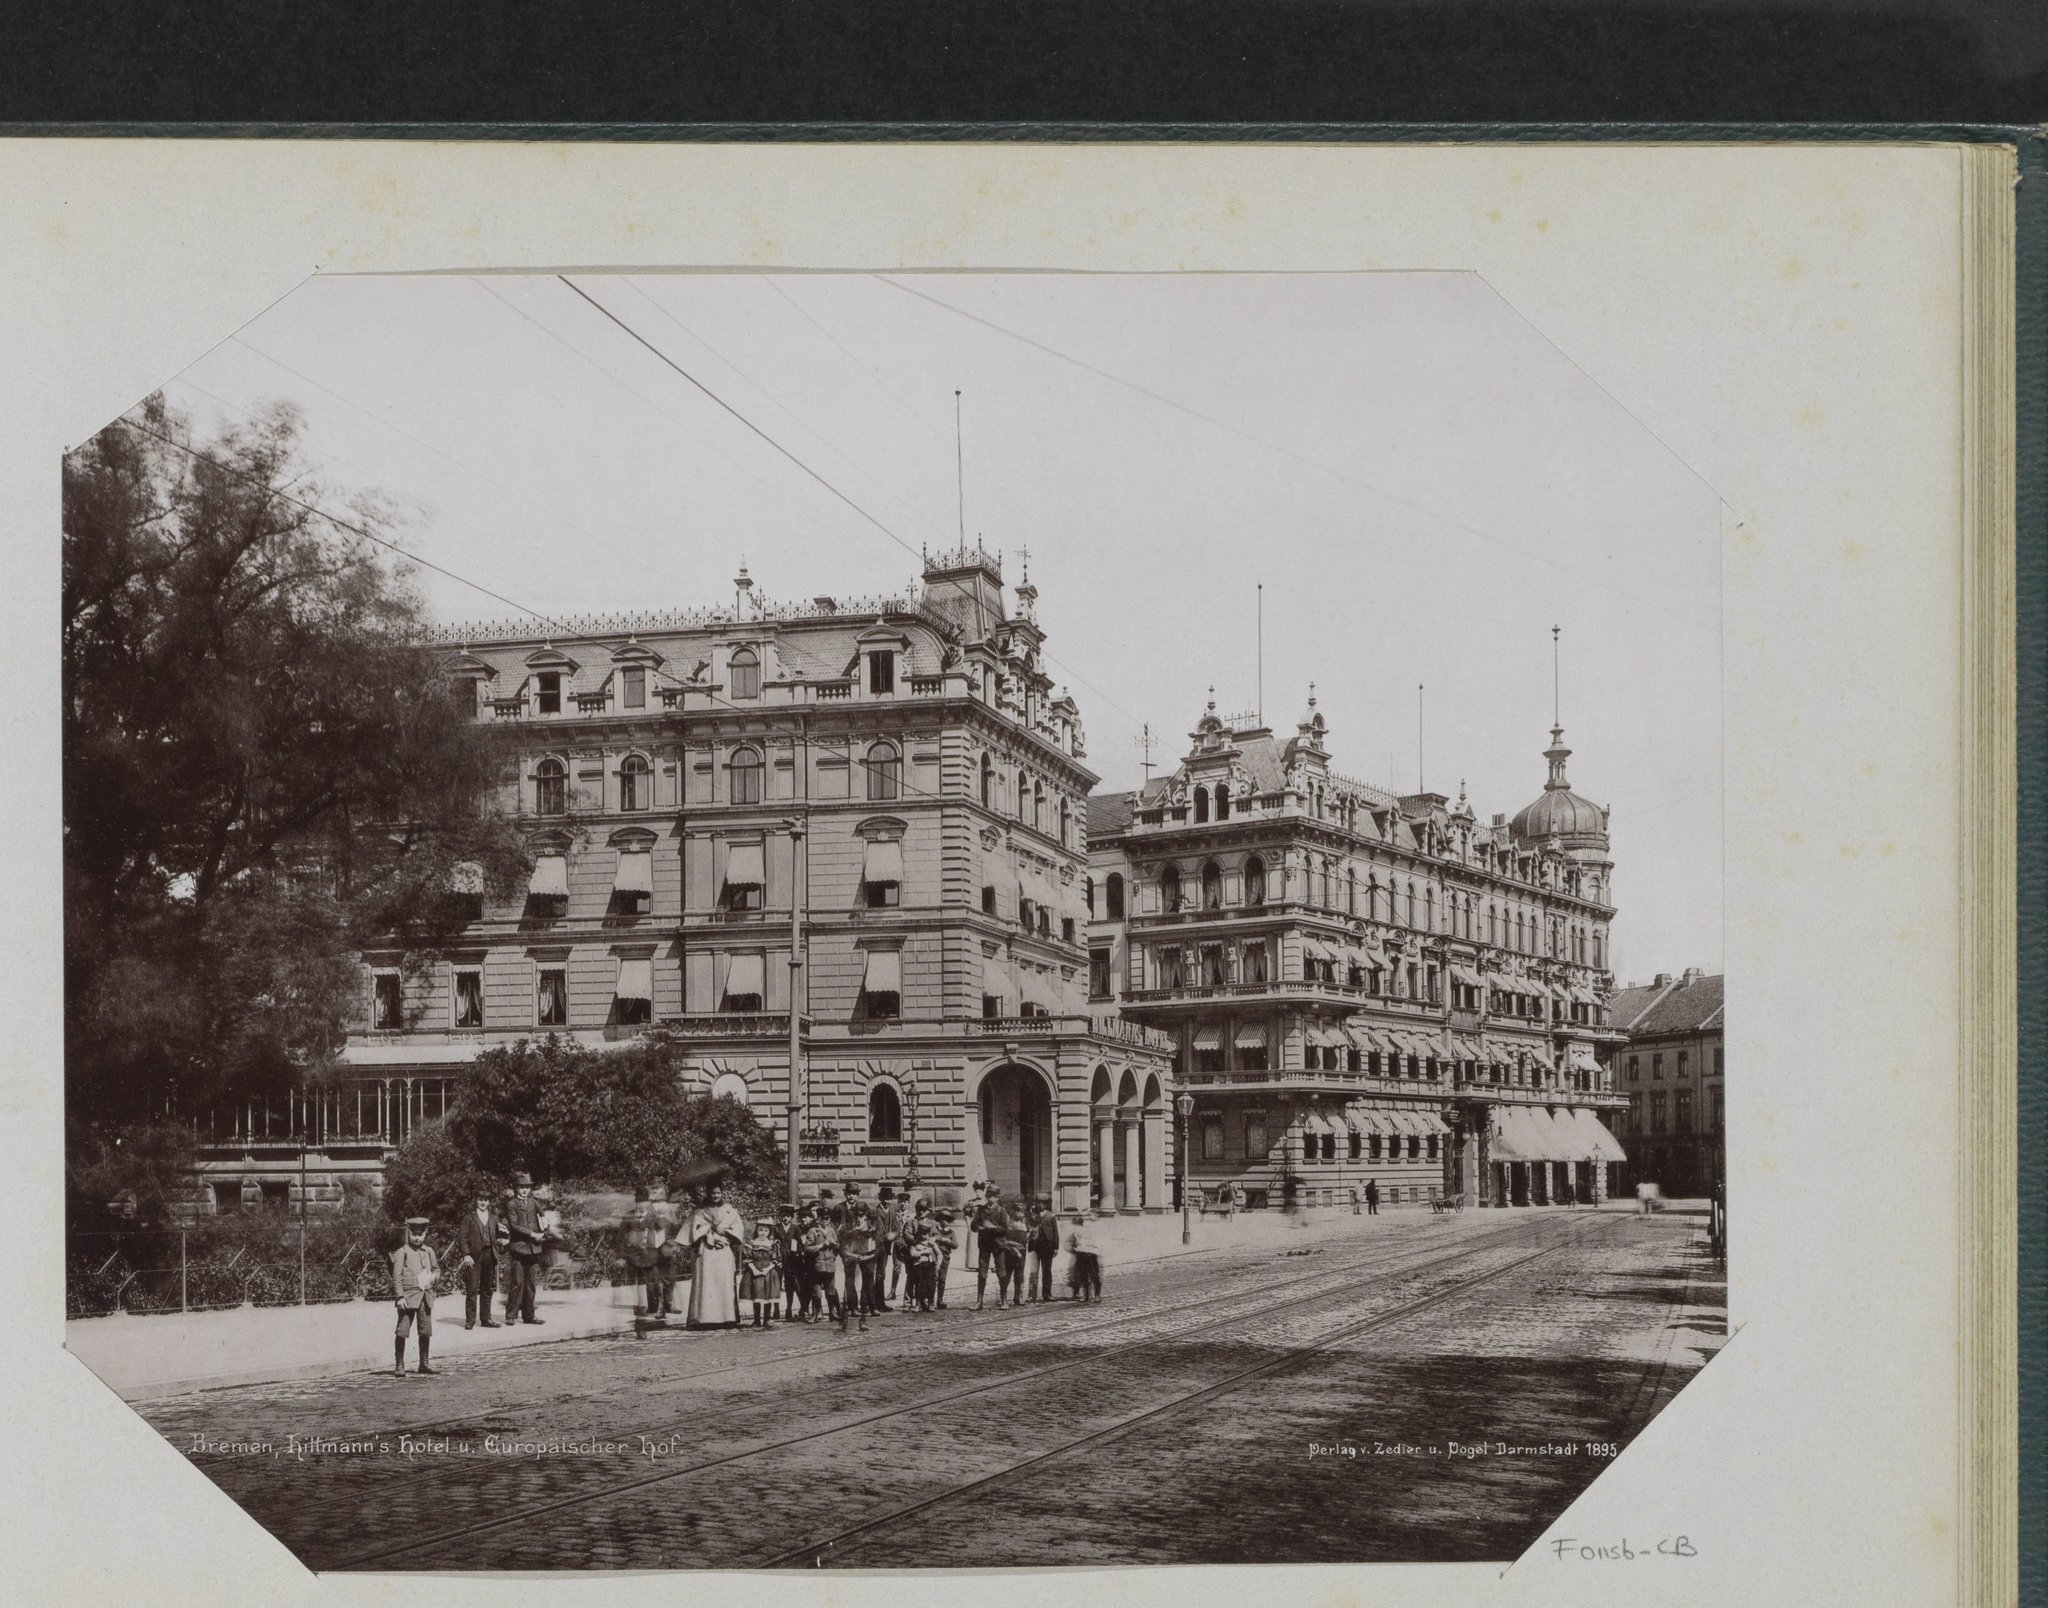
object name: album leaf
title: Gezicht op Hillmann's Hotel te Bremen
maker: Anonymous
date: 1895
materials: paper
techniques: photograph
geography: darmstadt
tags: hotel, hostelry, inn, street (+ city(-scape) with figures, staffage)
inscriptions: inscription: ‘Bremen, Hillmann's Hotel u. Europäischer Hof/ Verlag v. Zedler u. Vogel Darmstadt 1895’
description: Deze prent maakt deel uit van een album.